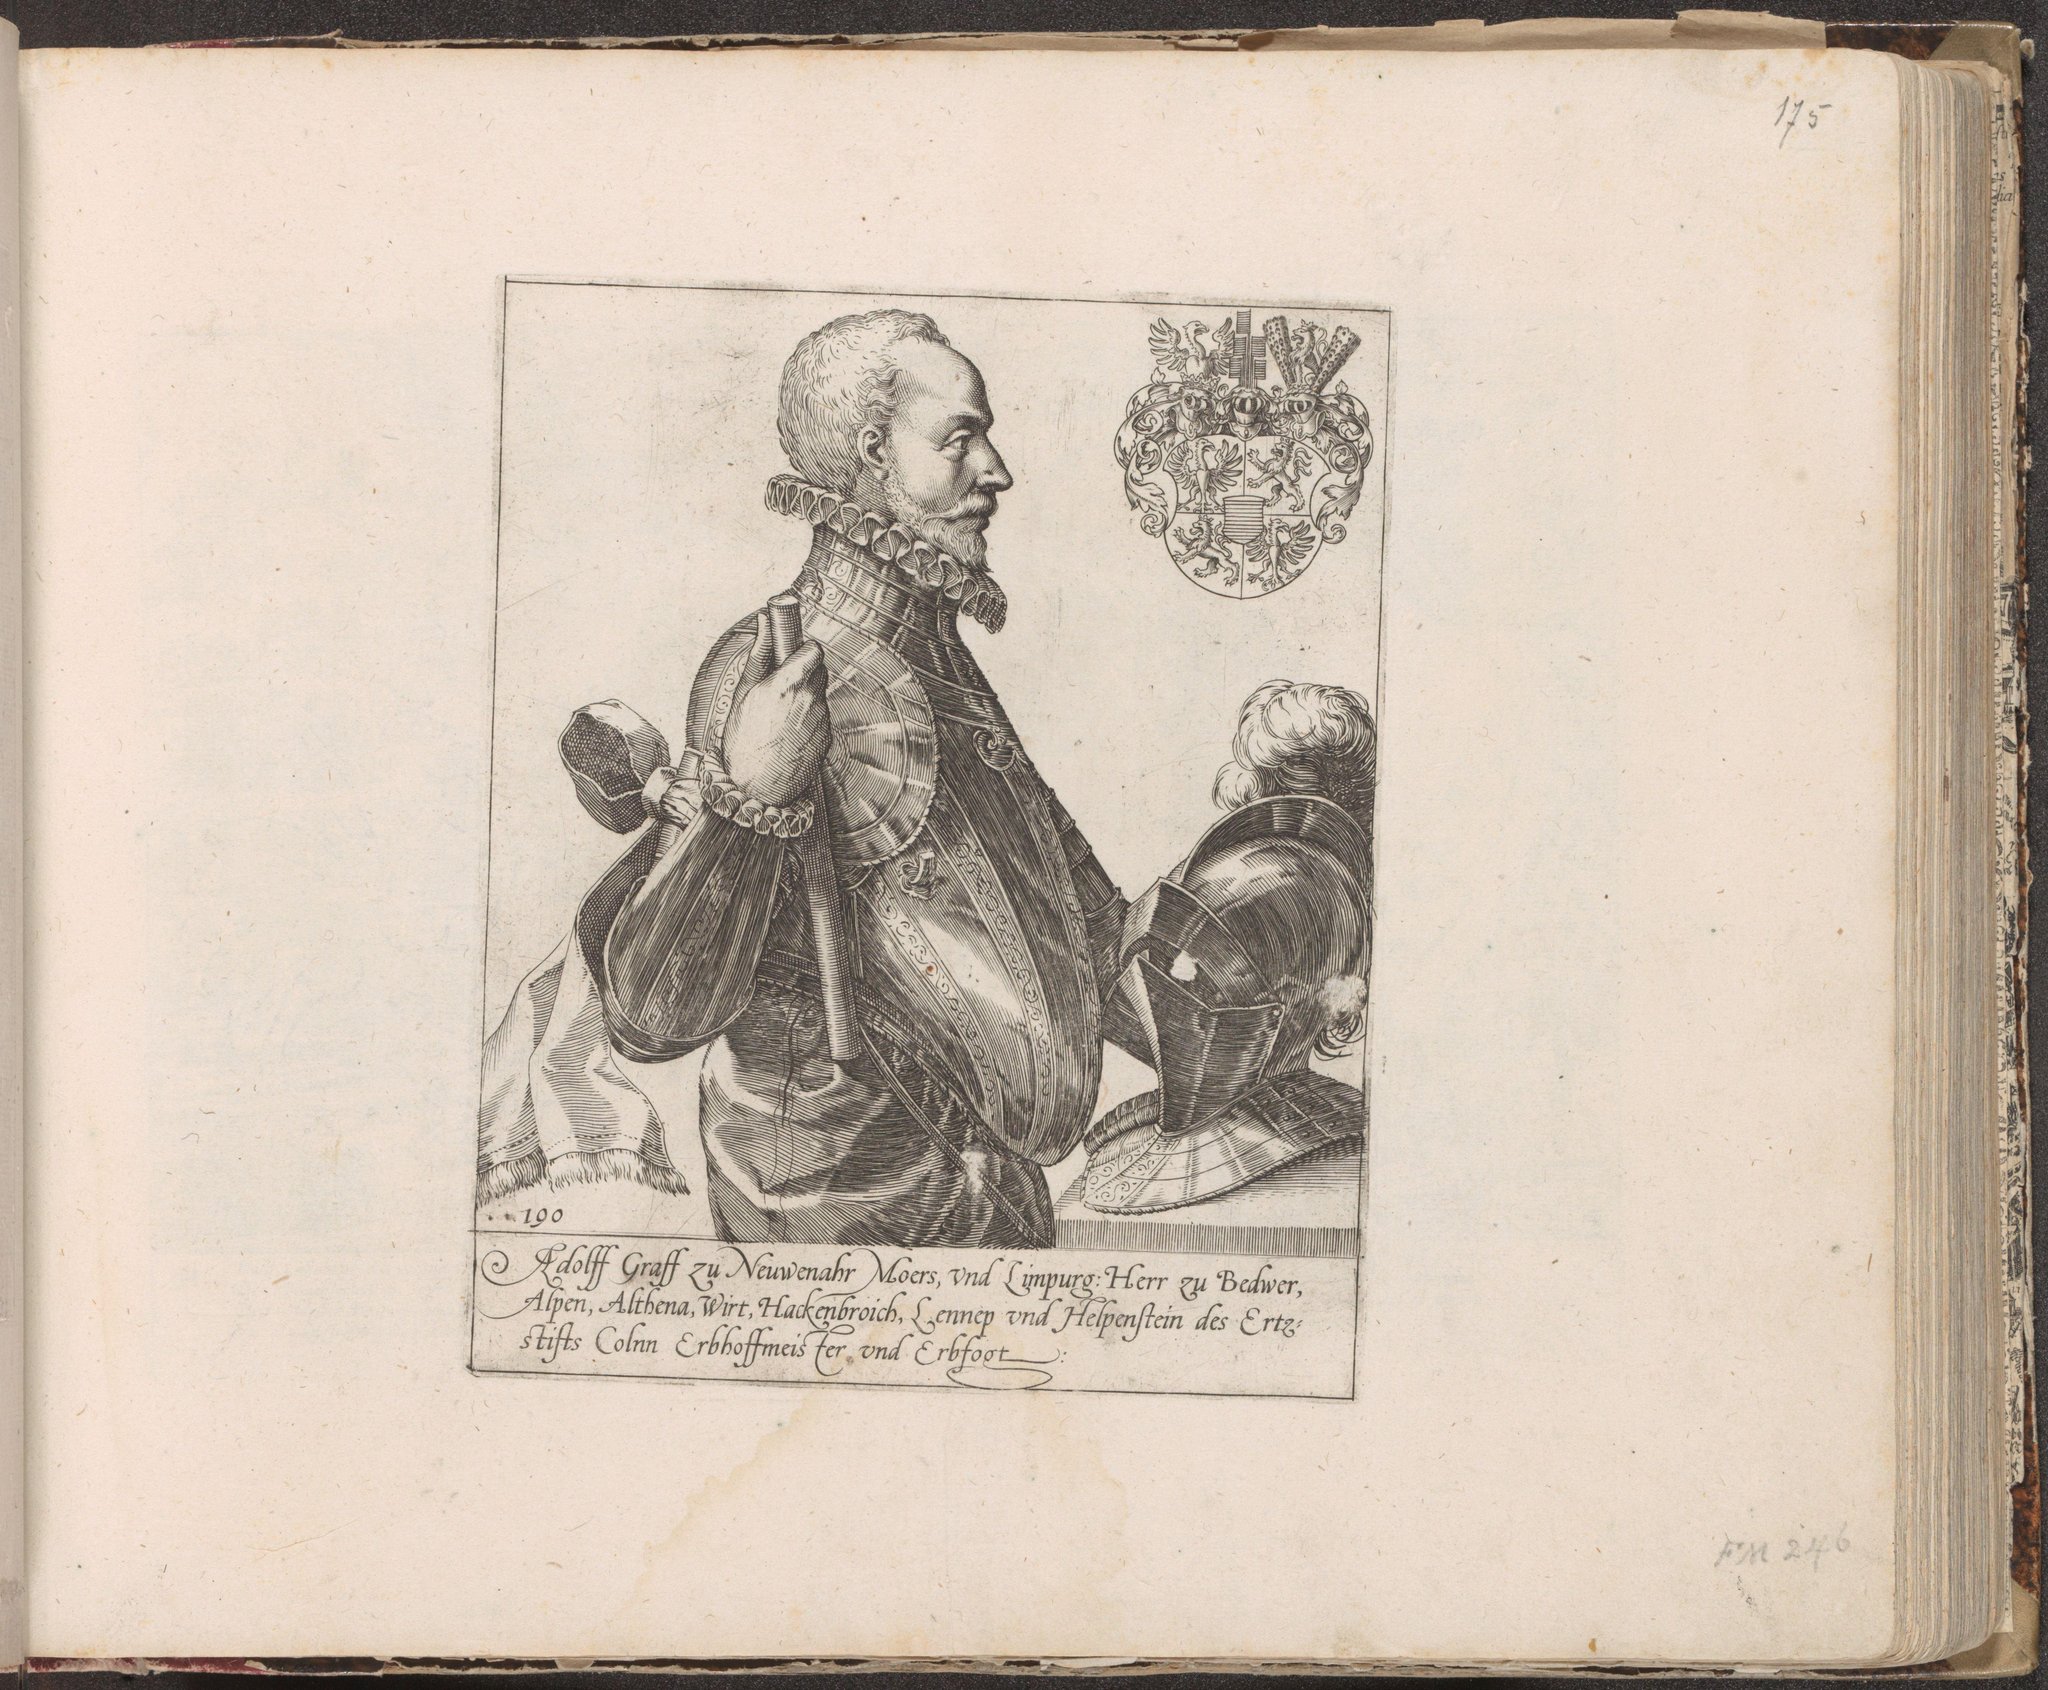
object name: print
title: Portret van Adolf, graaf van Nieuwenaar en Meurs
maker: frans hogenberg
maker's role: print maker, publisher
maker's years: 1538-1590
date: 1584-1620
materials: paper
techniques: engraving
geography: cologne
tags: arnhem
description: Portret van Adolf, graaf van Nieuwenaar en Meurs. Staande, ten halven lijve, profiel naar rechts, helm op tafel. Rechtsboven zijn wapen. Met onderschrift van 3 regels in het Duits. Linksonder genummerd: 190. De prent maakt deel uit van een album.